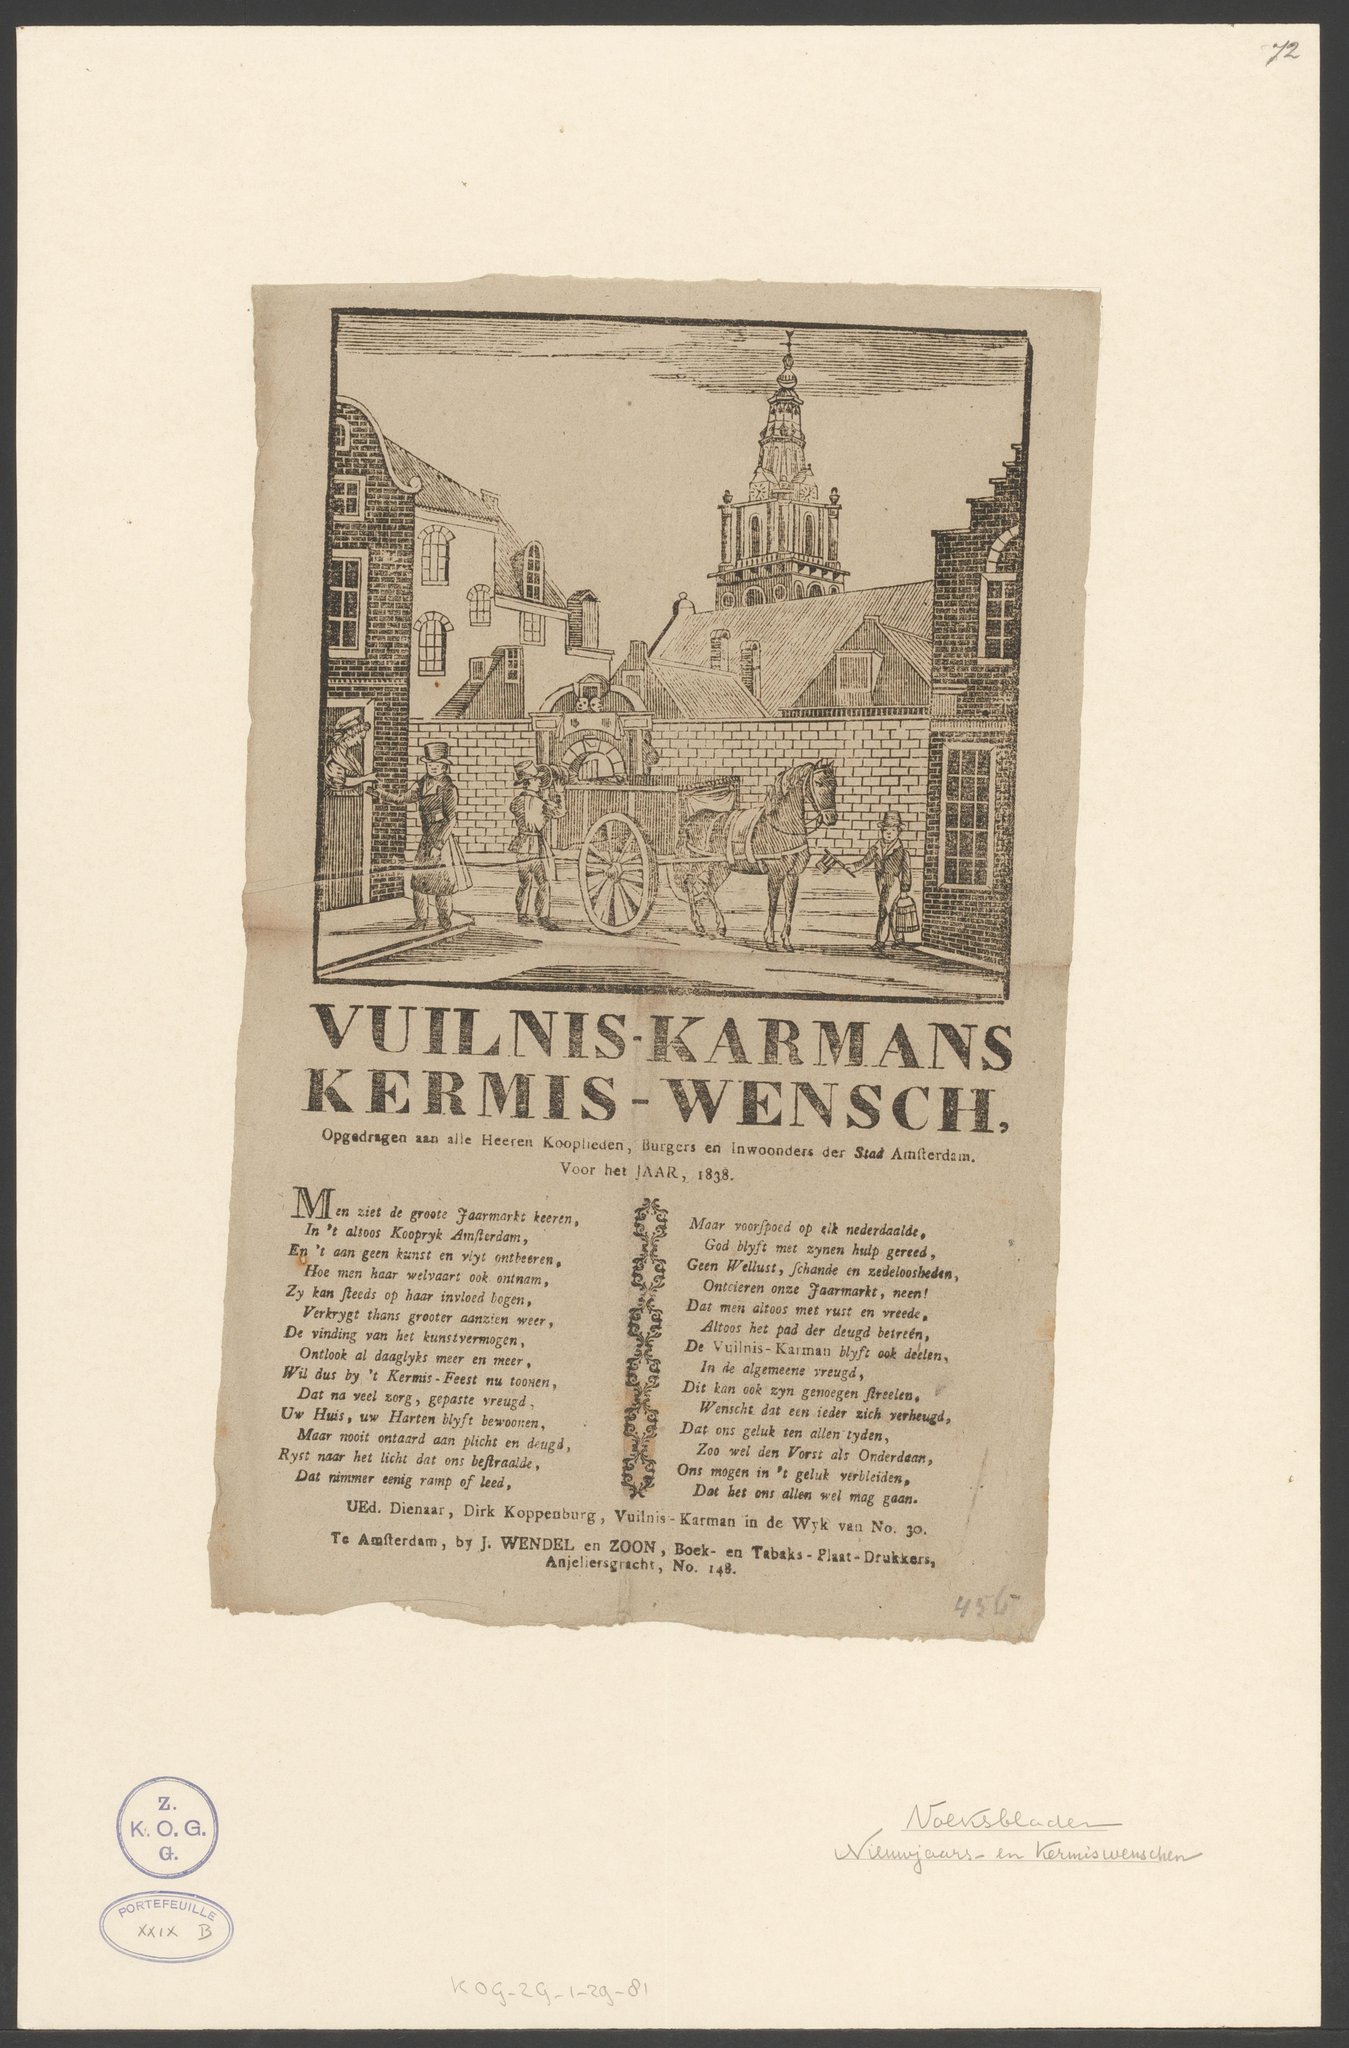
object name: print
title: Kermisprent van de vuilnismannen van Amsterdam voor het jaar 1838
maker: Anonymous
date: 1862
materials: paper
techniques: letterpress printing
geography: amsterdam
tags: street, garbage collection, amsterdam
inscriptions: collector's mark: Lugt 1641a, collector's mark: Lugt 1641, stamp:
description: Kermisprent van de Amsterdamse vuilnismannen voor het jaar 1838. Gezicht bij de Sint-Antoniesbreestraat en het poortje naar de Zuiderkerkhof bij de Zuiderkerk te Amsterdam, waar een man een vuilnisemmer in de kar leegkiepert en een andere man met de ratel draait. Een andere man haalt bij een huis geld op. Met gedicht in twee kolommen. Van de vuilniskarman in de wijk no. 30: Dirk Koppenburg. Onderwerpsrubrieken binnen de Atlas Zeden en Gewoonten: Zeden en gewoonten in engeren zin, Volksleven, Volksbladen, Nieuwjaars- en Kerstwenschen, Amsterdam.